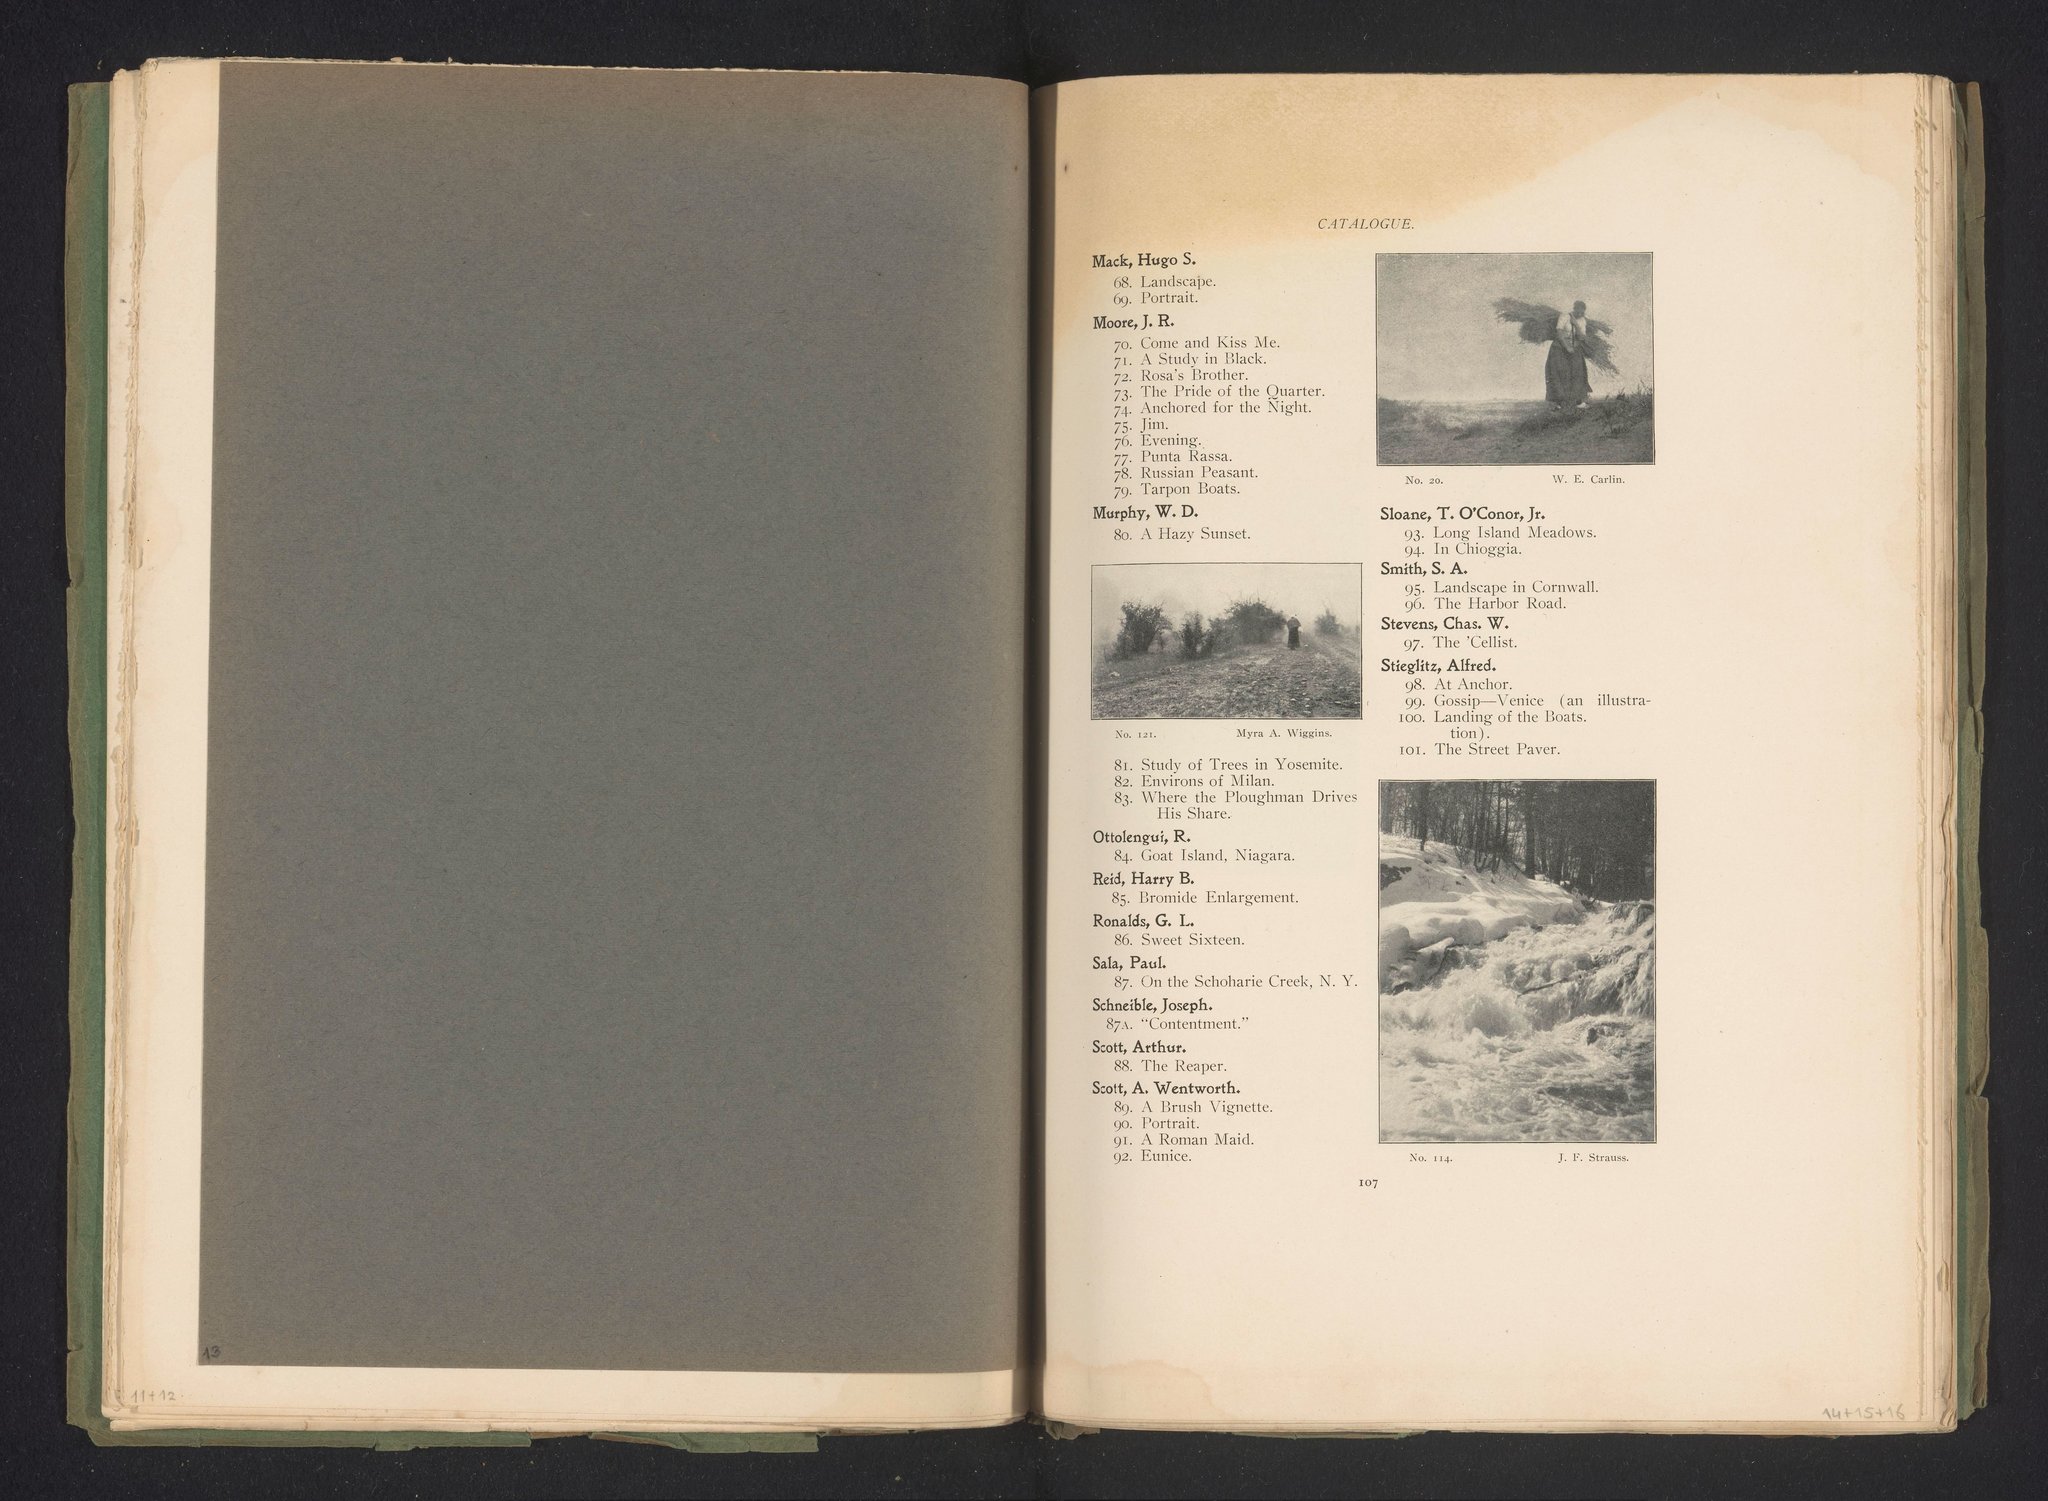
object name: photomechanical print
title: Vrouw op een landweg, op de rug gezien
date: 1895-1900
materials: paper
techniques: autotype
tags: adult woman, road, path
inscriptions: number: ‘No. 121’